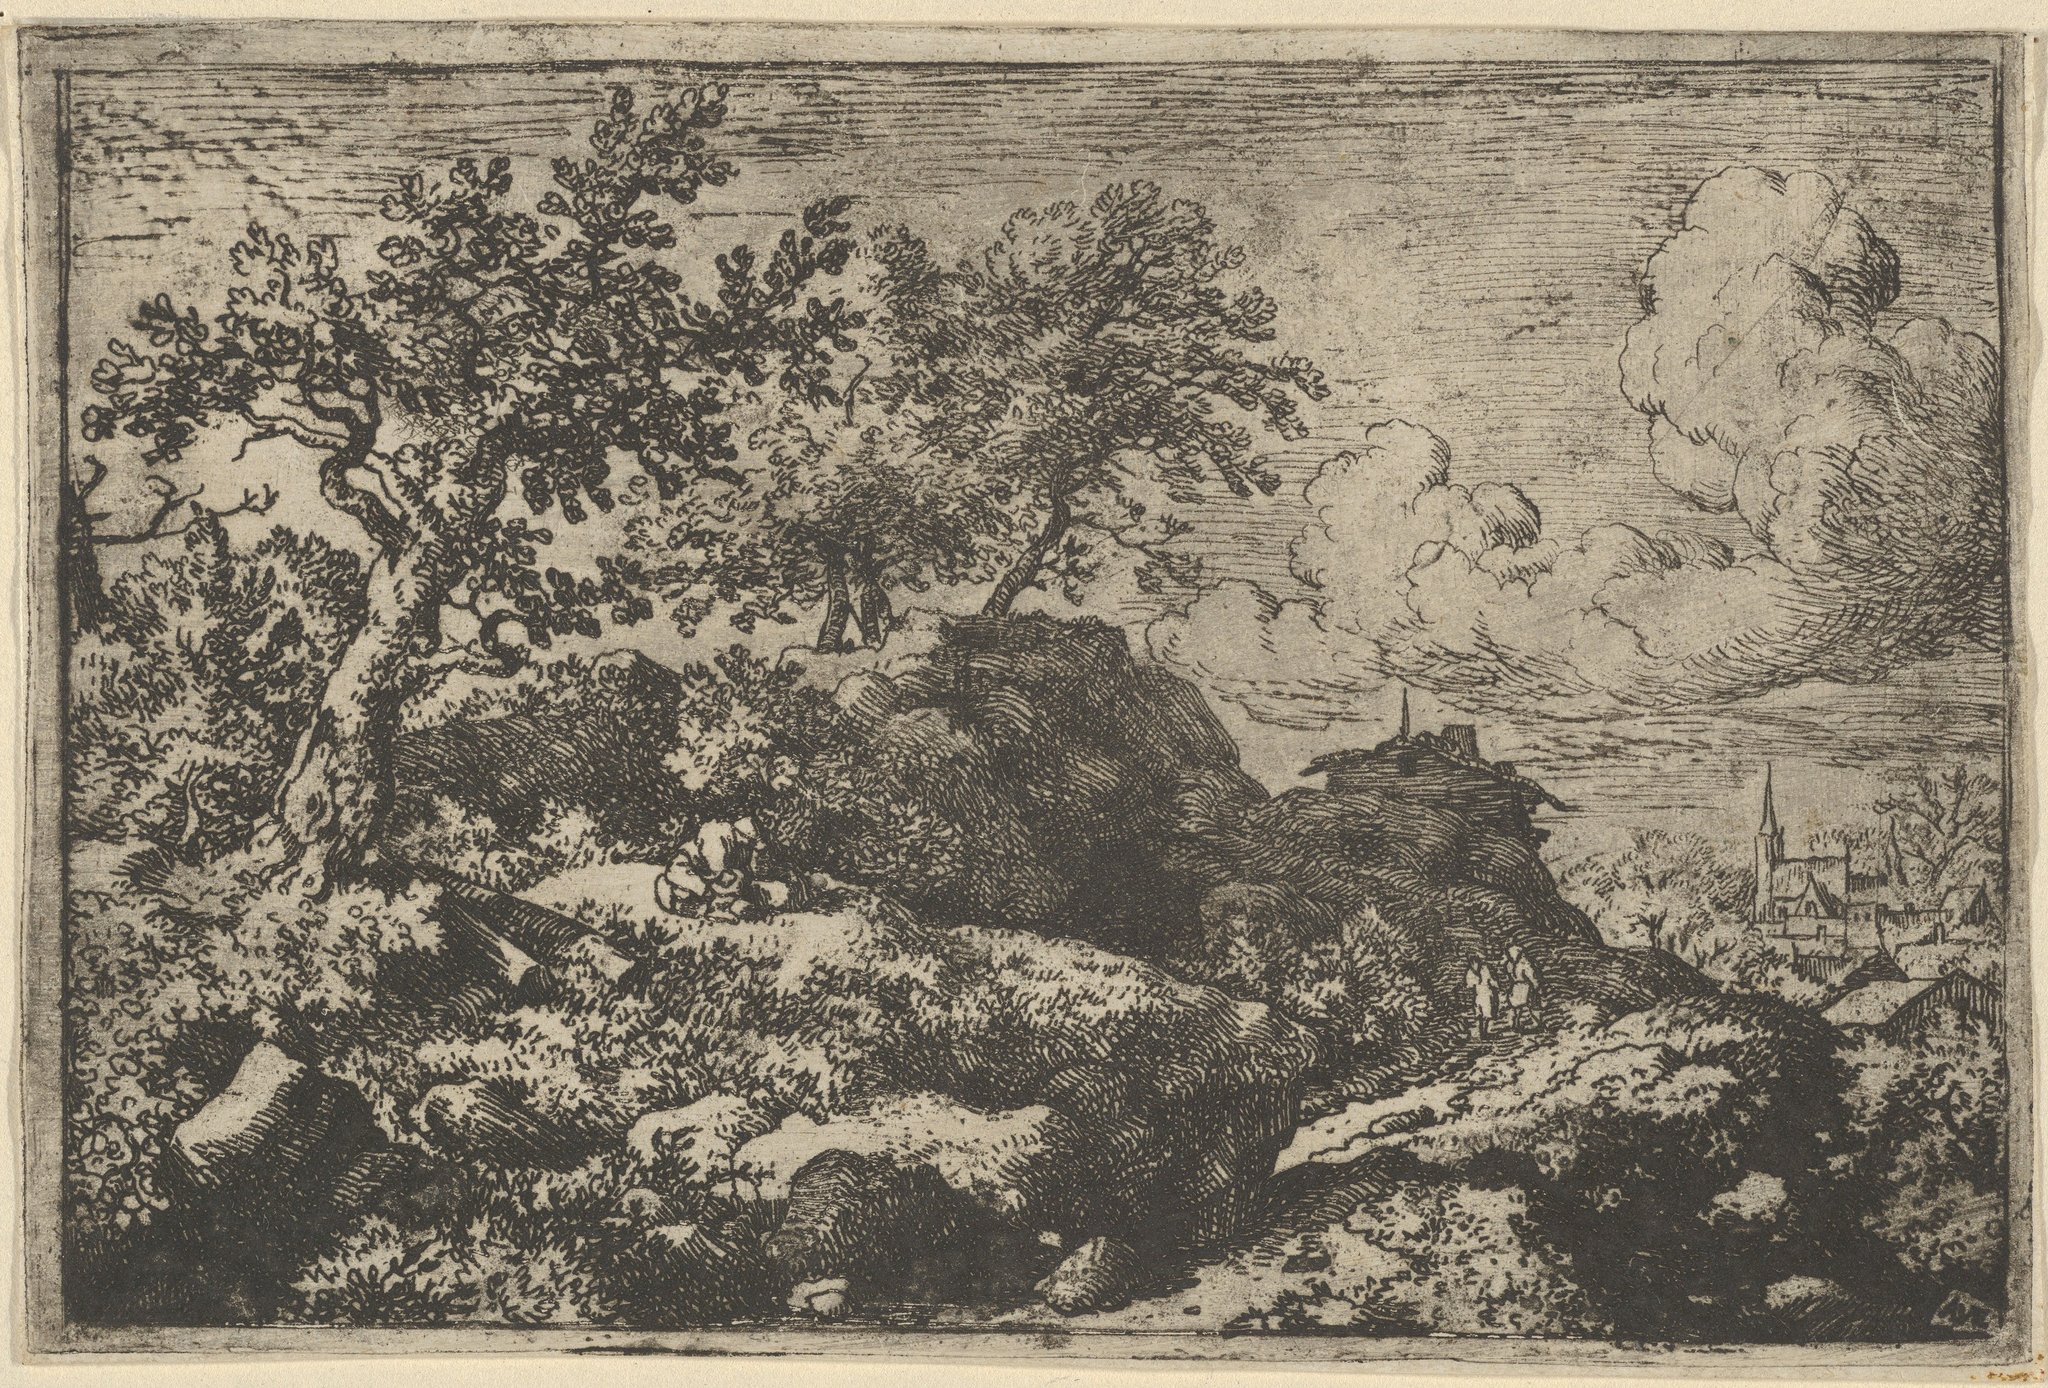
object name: print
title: The Two Peasants Seated on the Hill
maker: allart van everdingen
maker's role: artist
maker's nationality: dutch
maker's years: 1621-1675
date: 1621-1675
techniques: engraving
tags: human figures,hills,trees